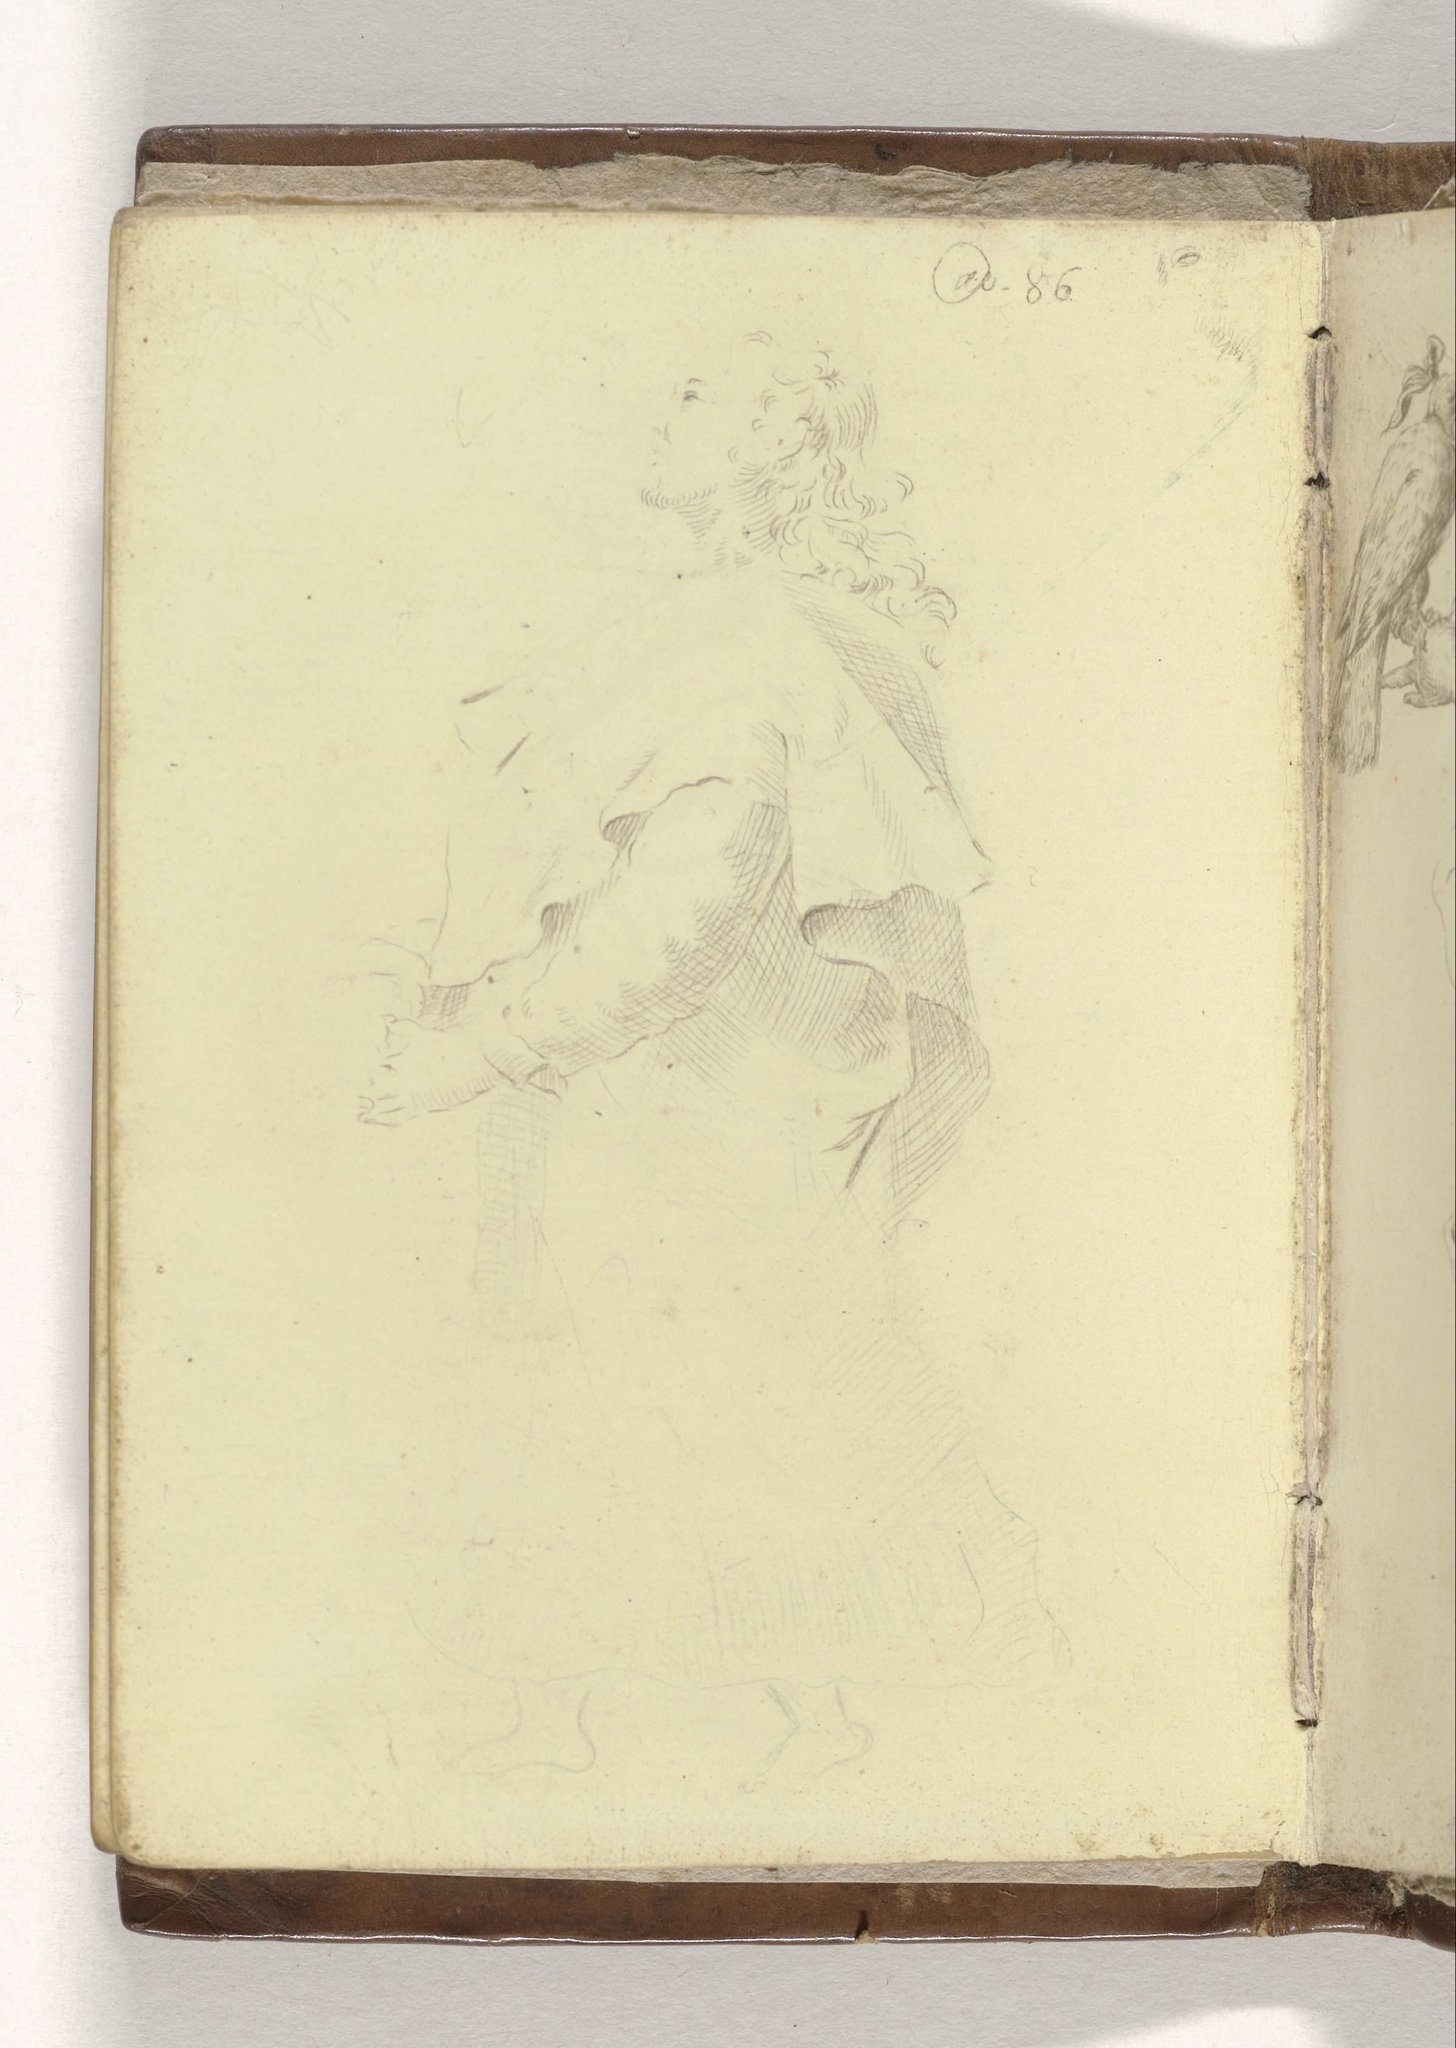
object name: drawing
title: Johannes de Evangelist onder het kruis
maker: Anonymous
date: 1586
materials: paper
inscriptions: date